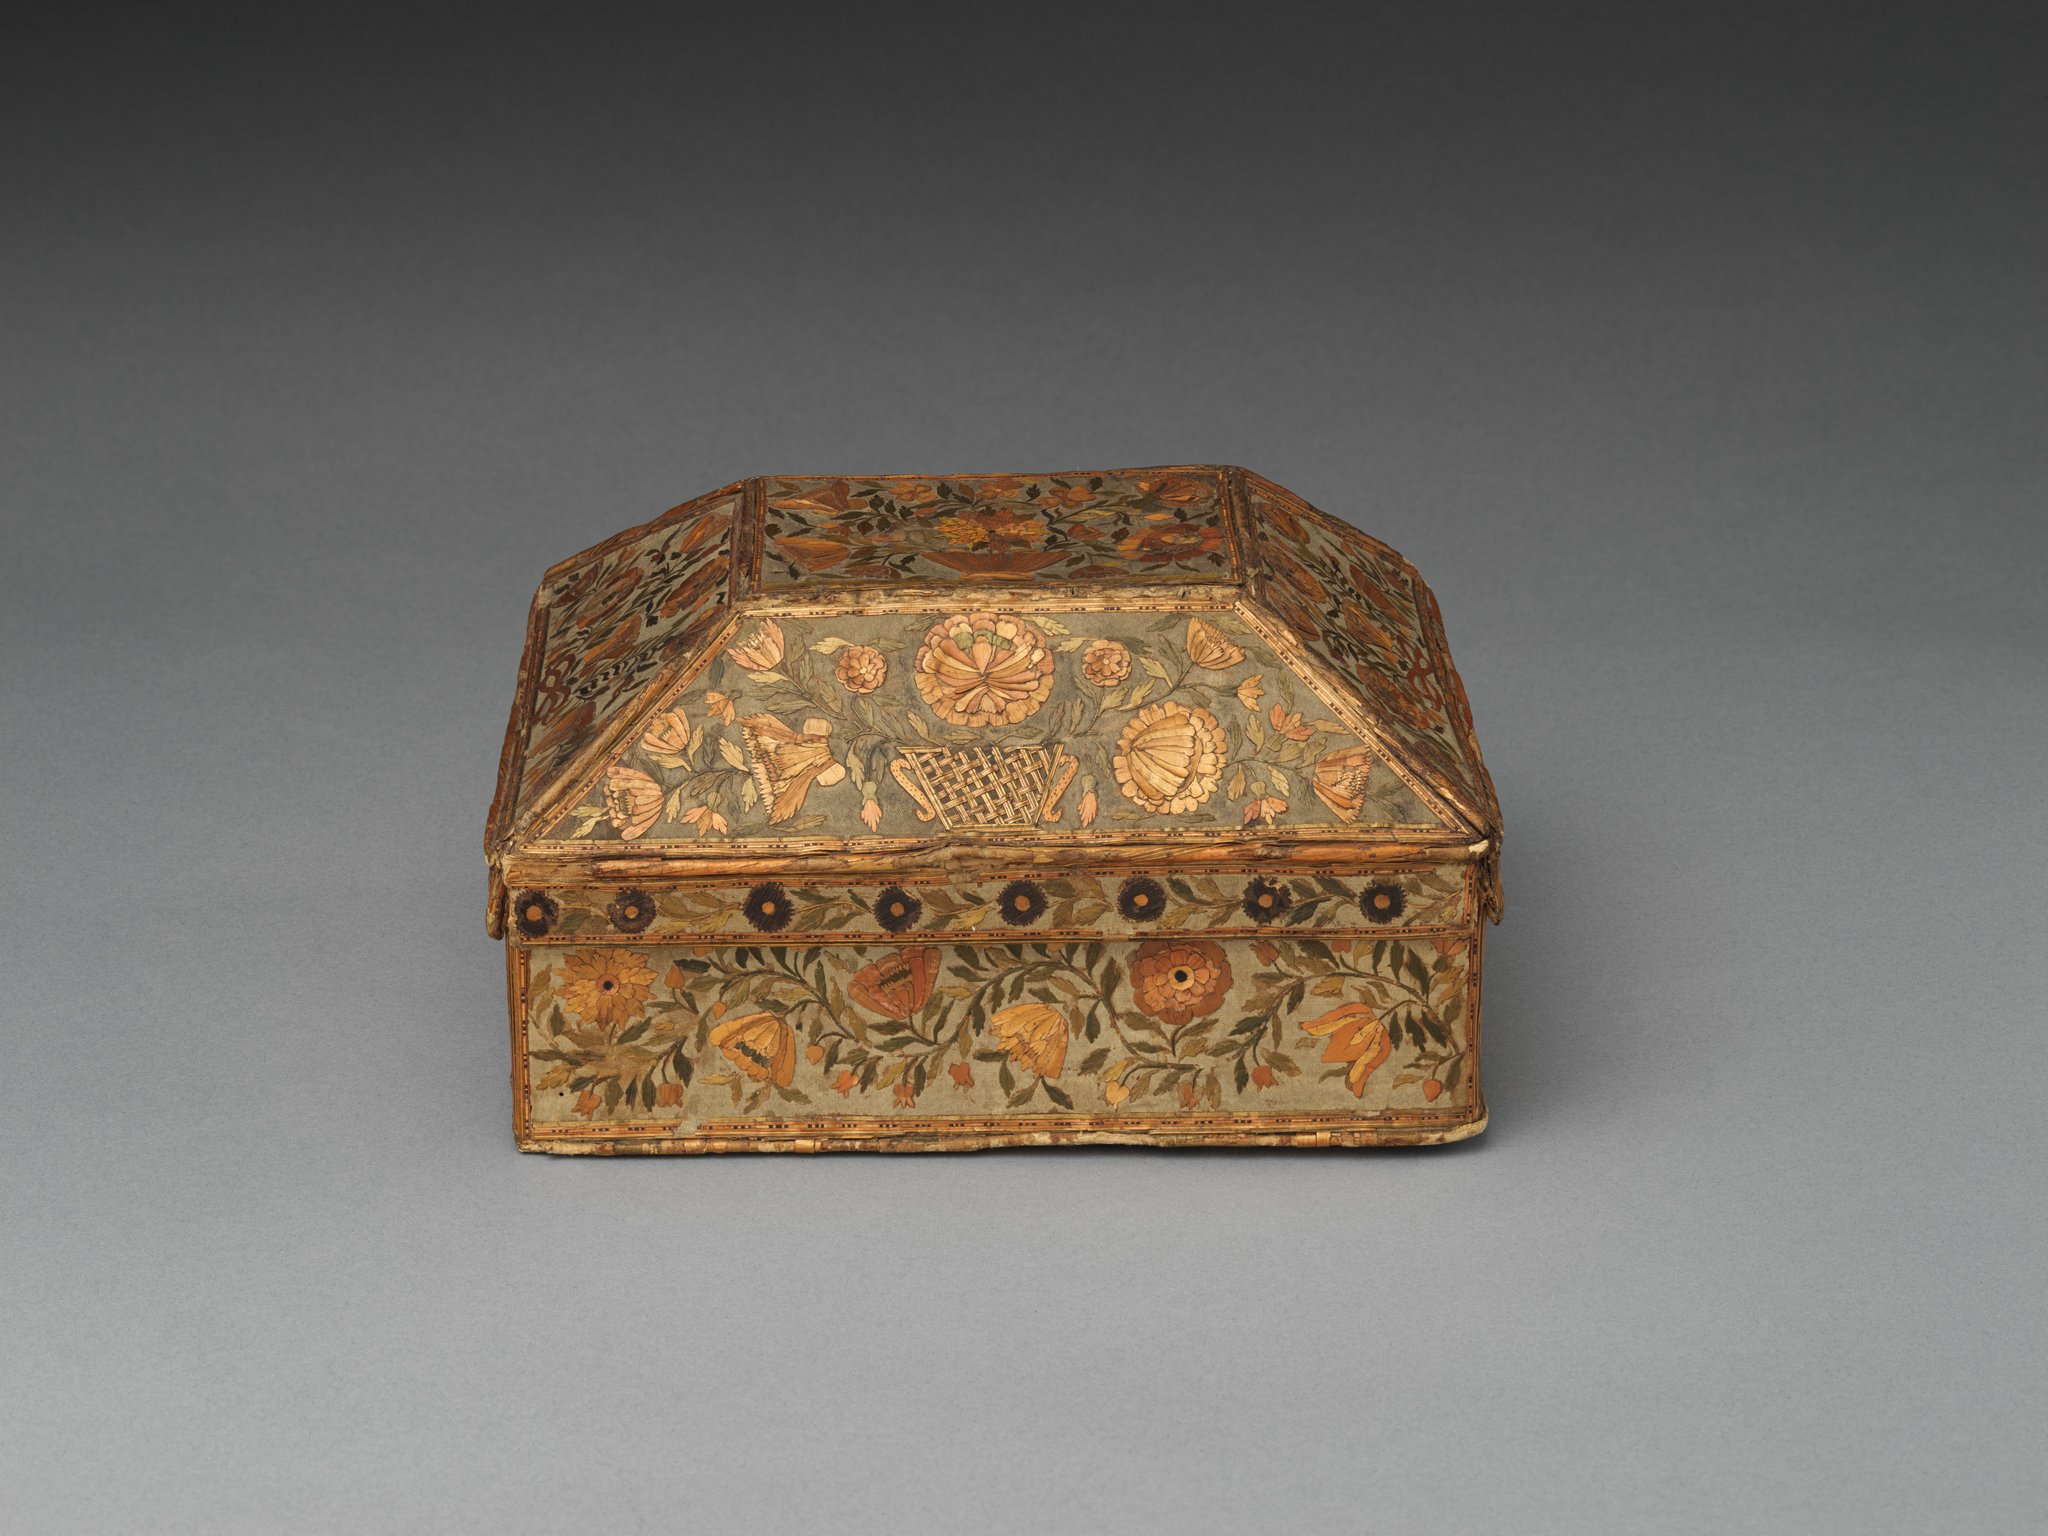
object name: box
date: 1701-1800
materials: cardboard, paper, silk, fiber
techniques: lining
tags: flowers